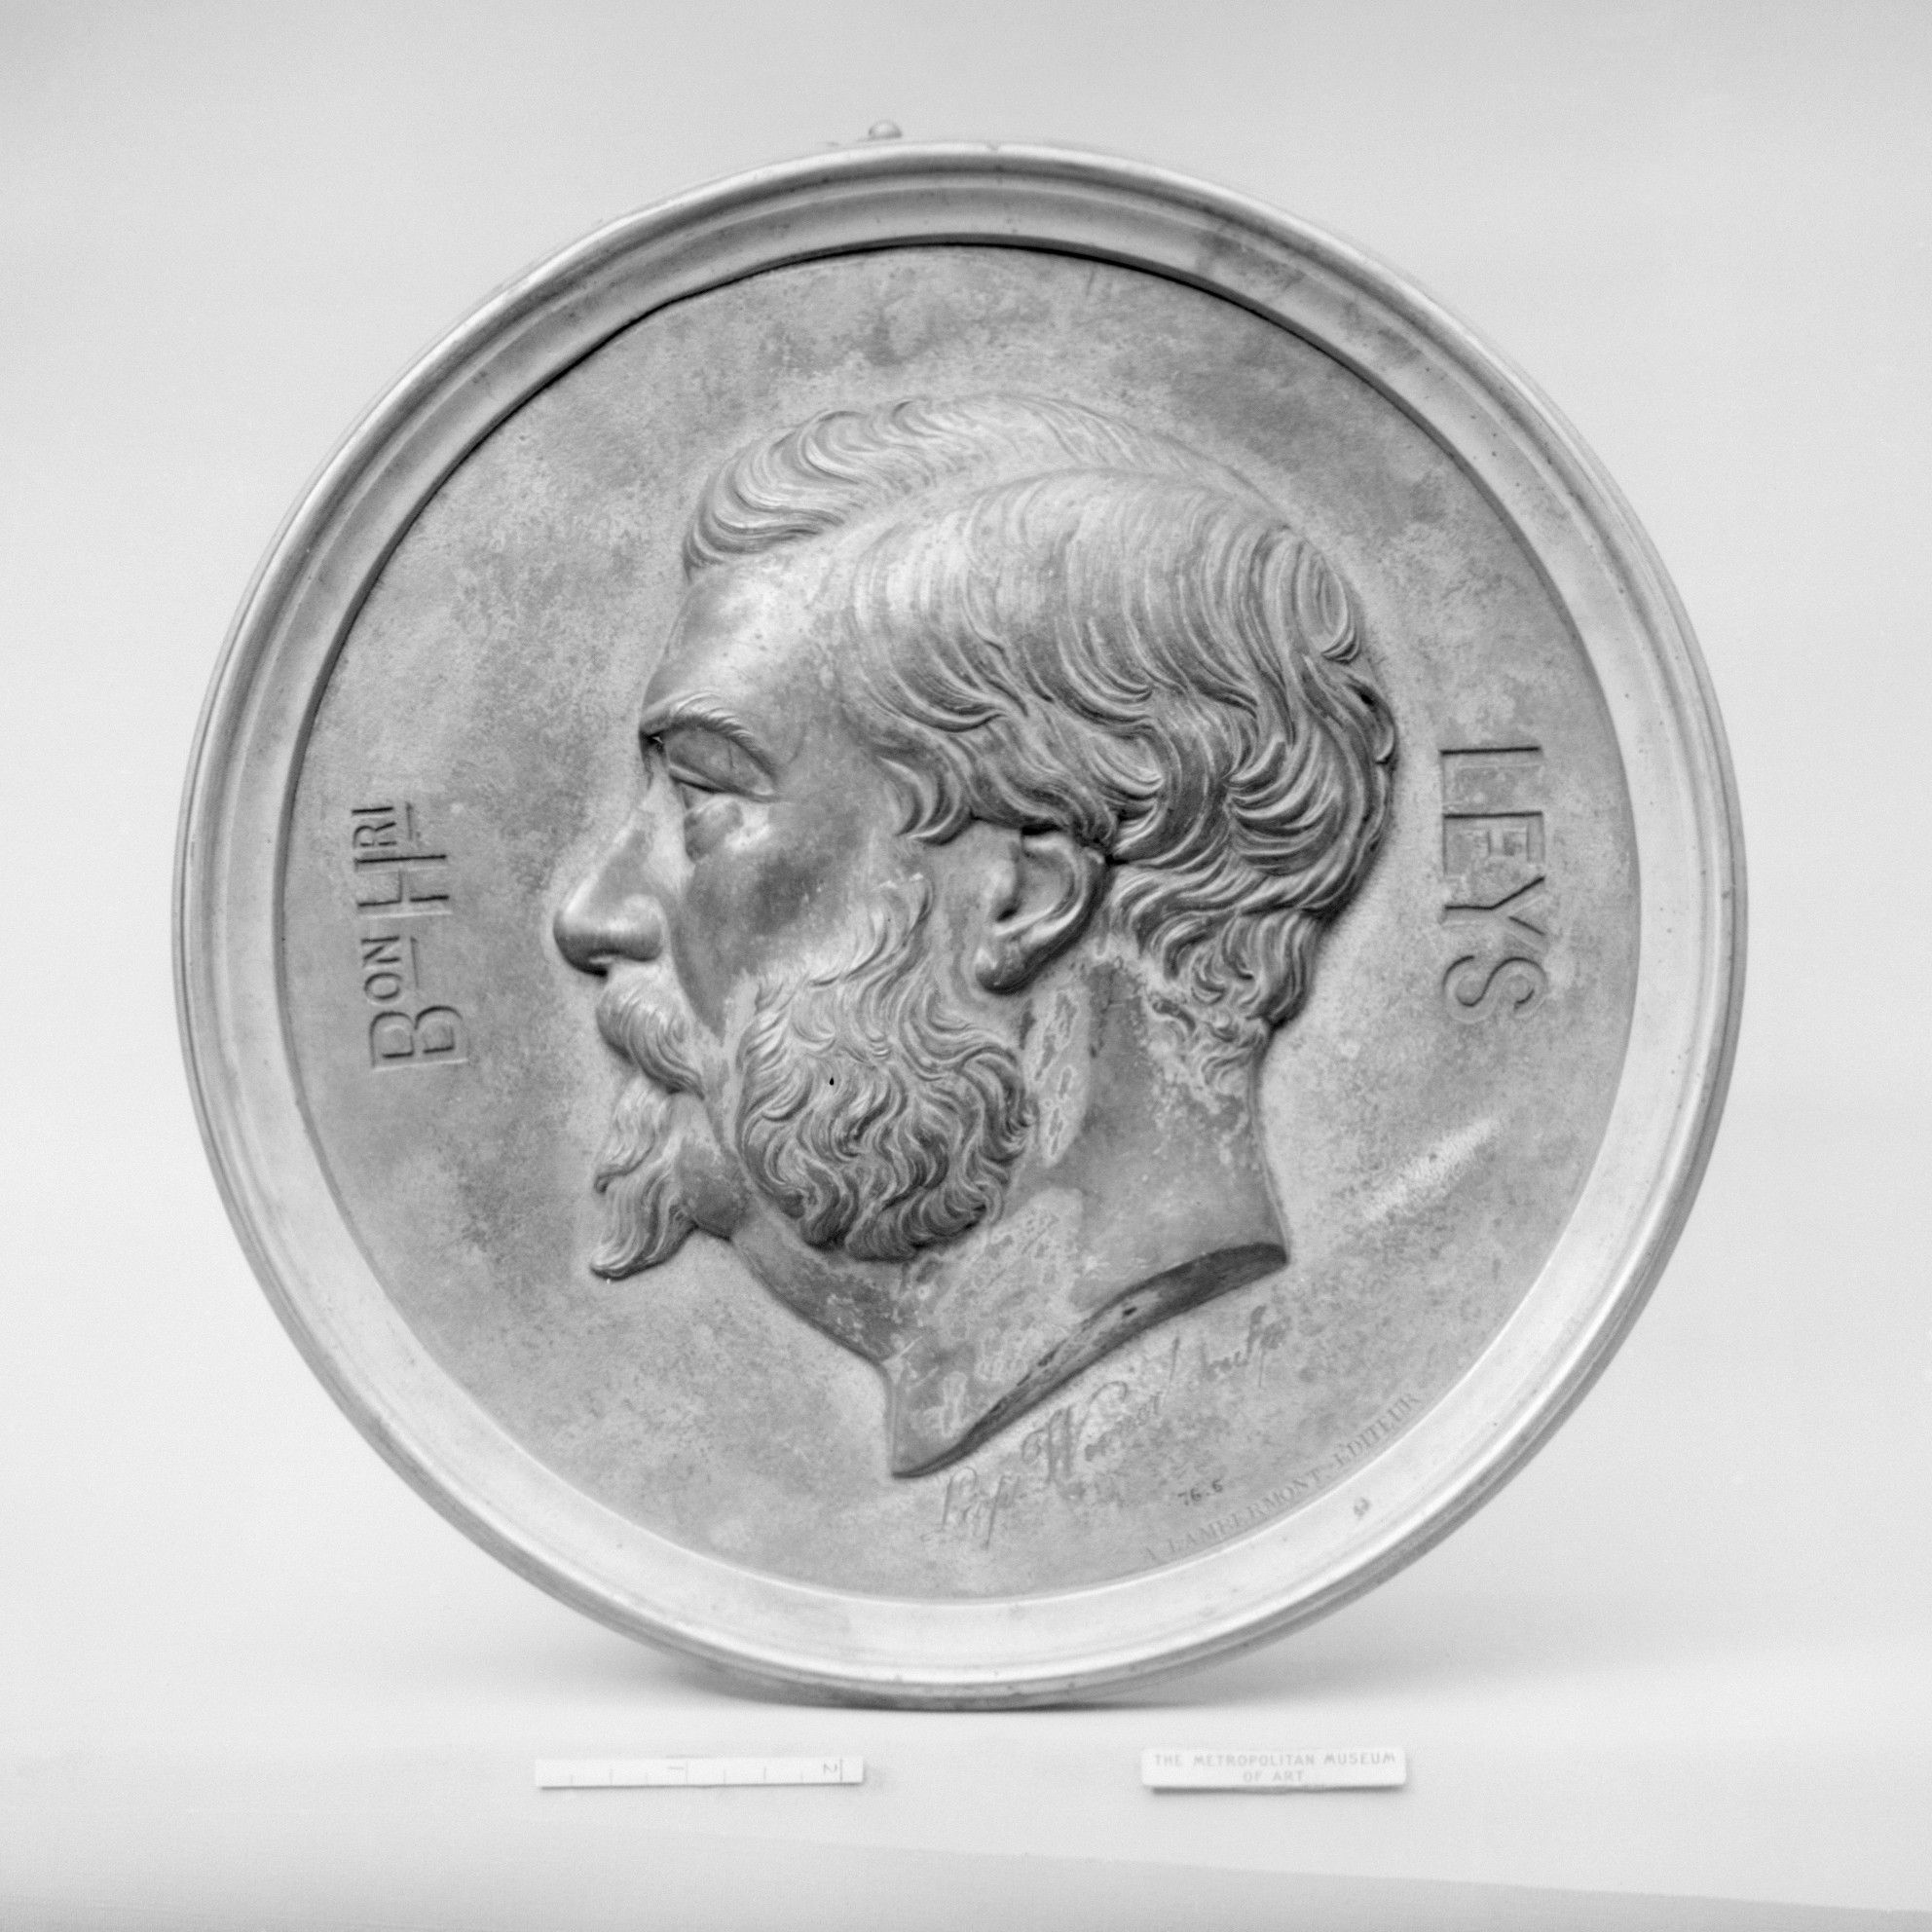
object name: medallion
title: Baron Henri Leys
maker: leopold wiener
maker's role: artist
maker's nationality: belgian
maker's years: 1823-1891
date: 1801-1900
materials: brass, gilt, silver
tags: men,profiles